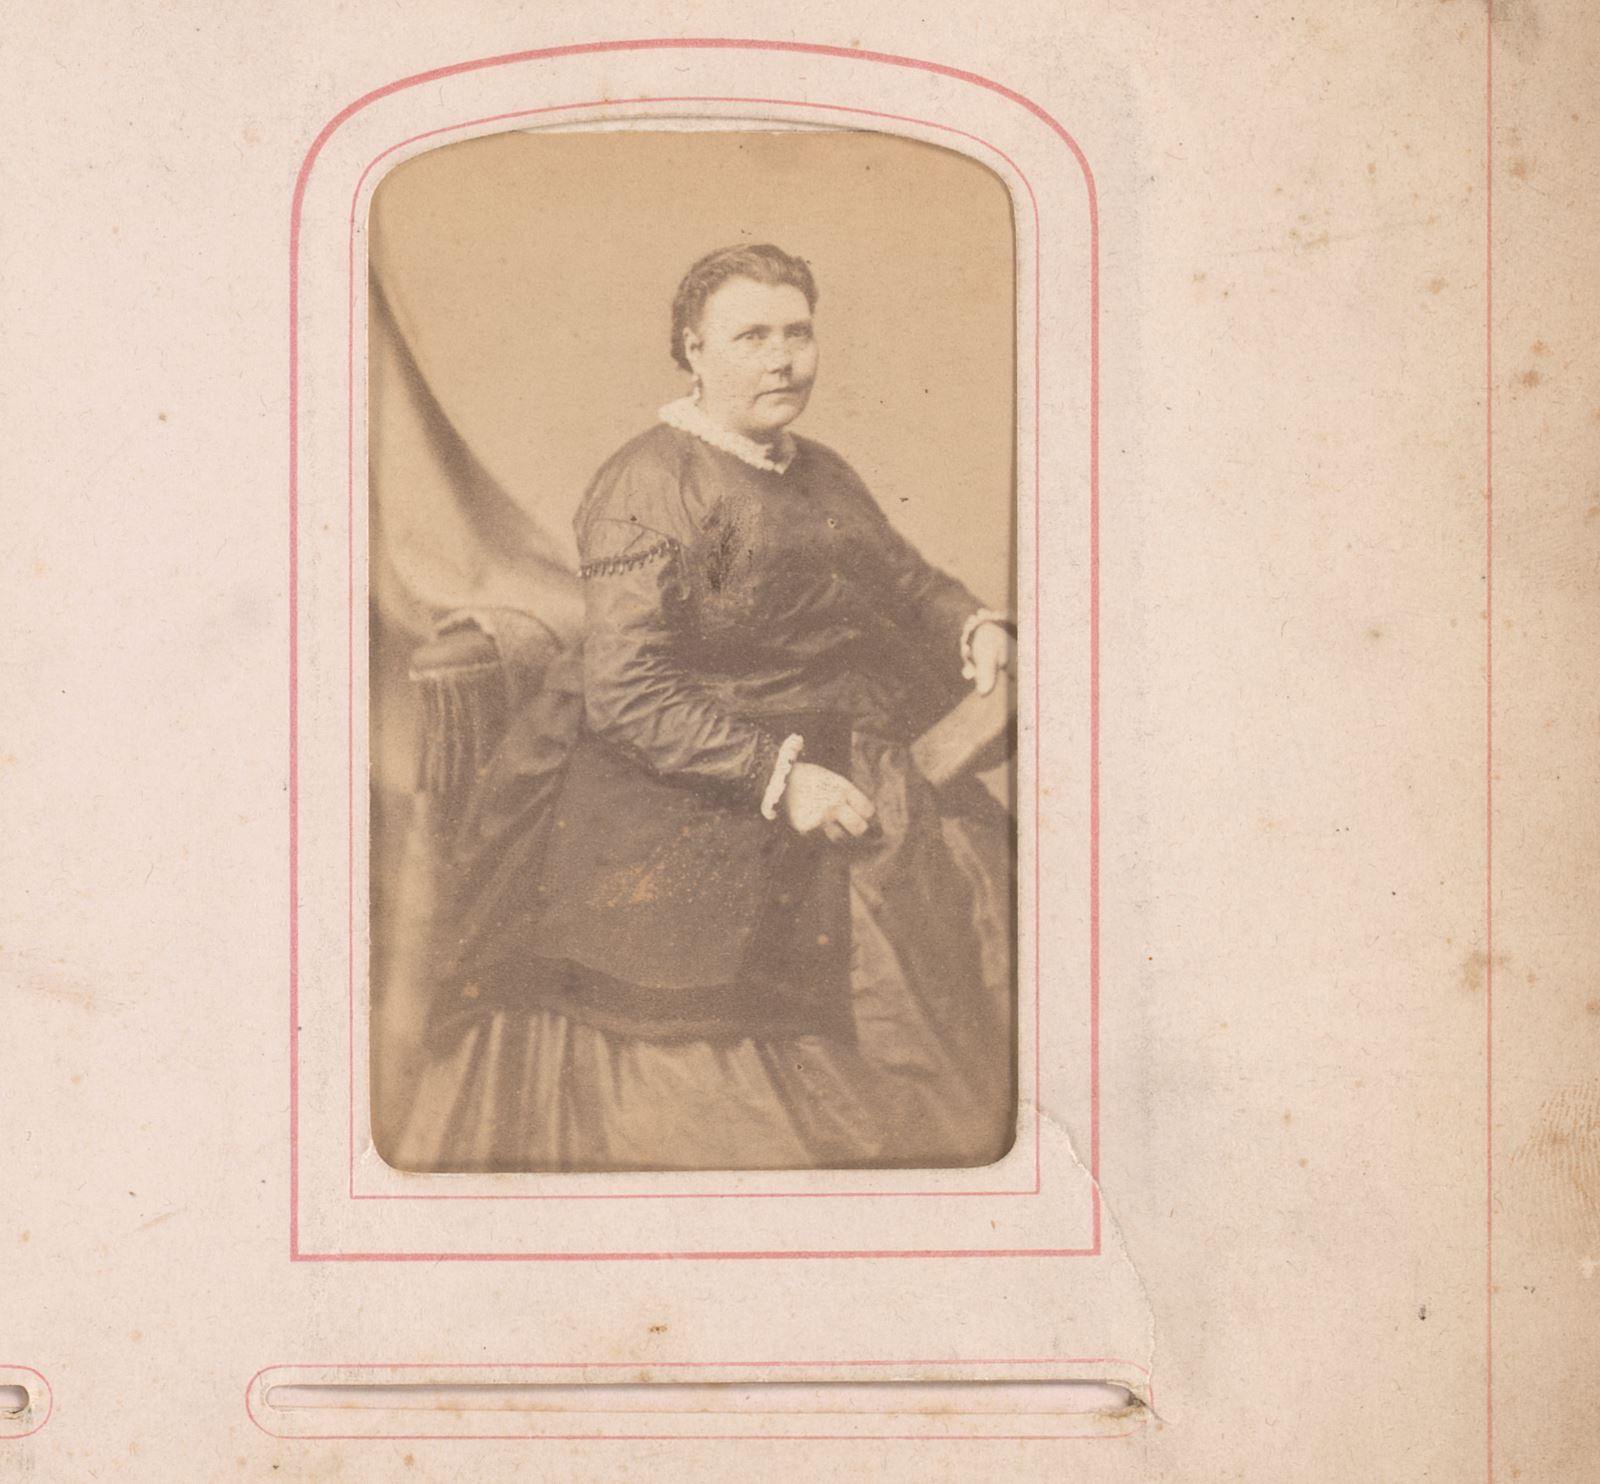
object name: carte de visite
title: Portret van een zittende vrouw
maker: willem gerhardus kuijer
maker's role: fotograaf, hoffotograaf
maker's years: 1834-1899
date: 1867-1880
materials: cardboard, paper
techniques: albumen print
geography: amsterdam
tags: adult woman, historical persons, amsterdam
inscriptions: inscription: ‘Photographisch/ Atelier/ van/ W.G. Kuijer/ Rozengracht/ tusschen de 1e en 2e Bloemdwarsstraat/ DD. 455/ Amsterdam’